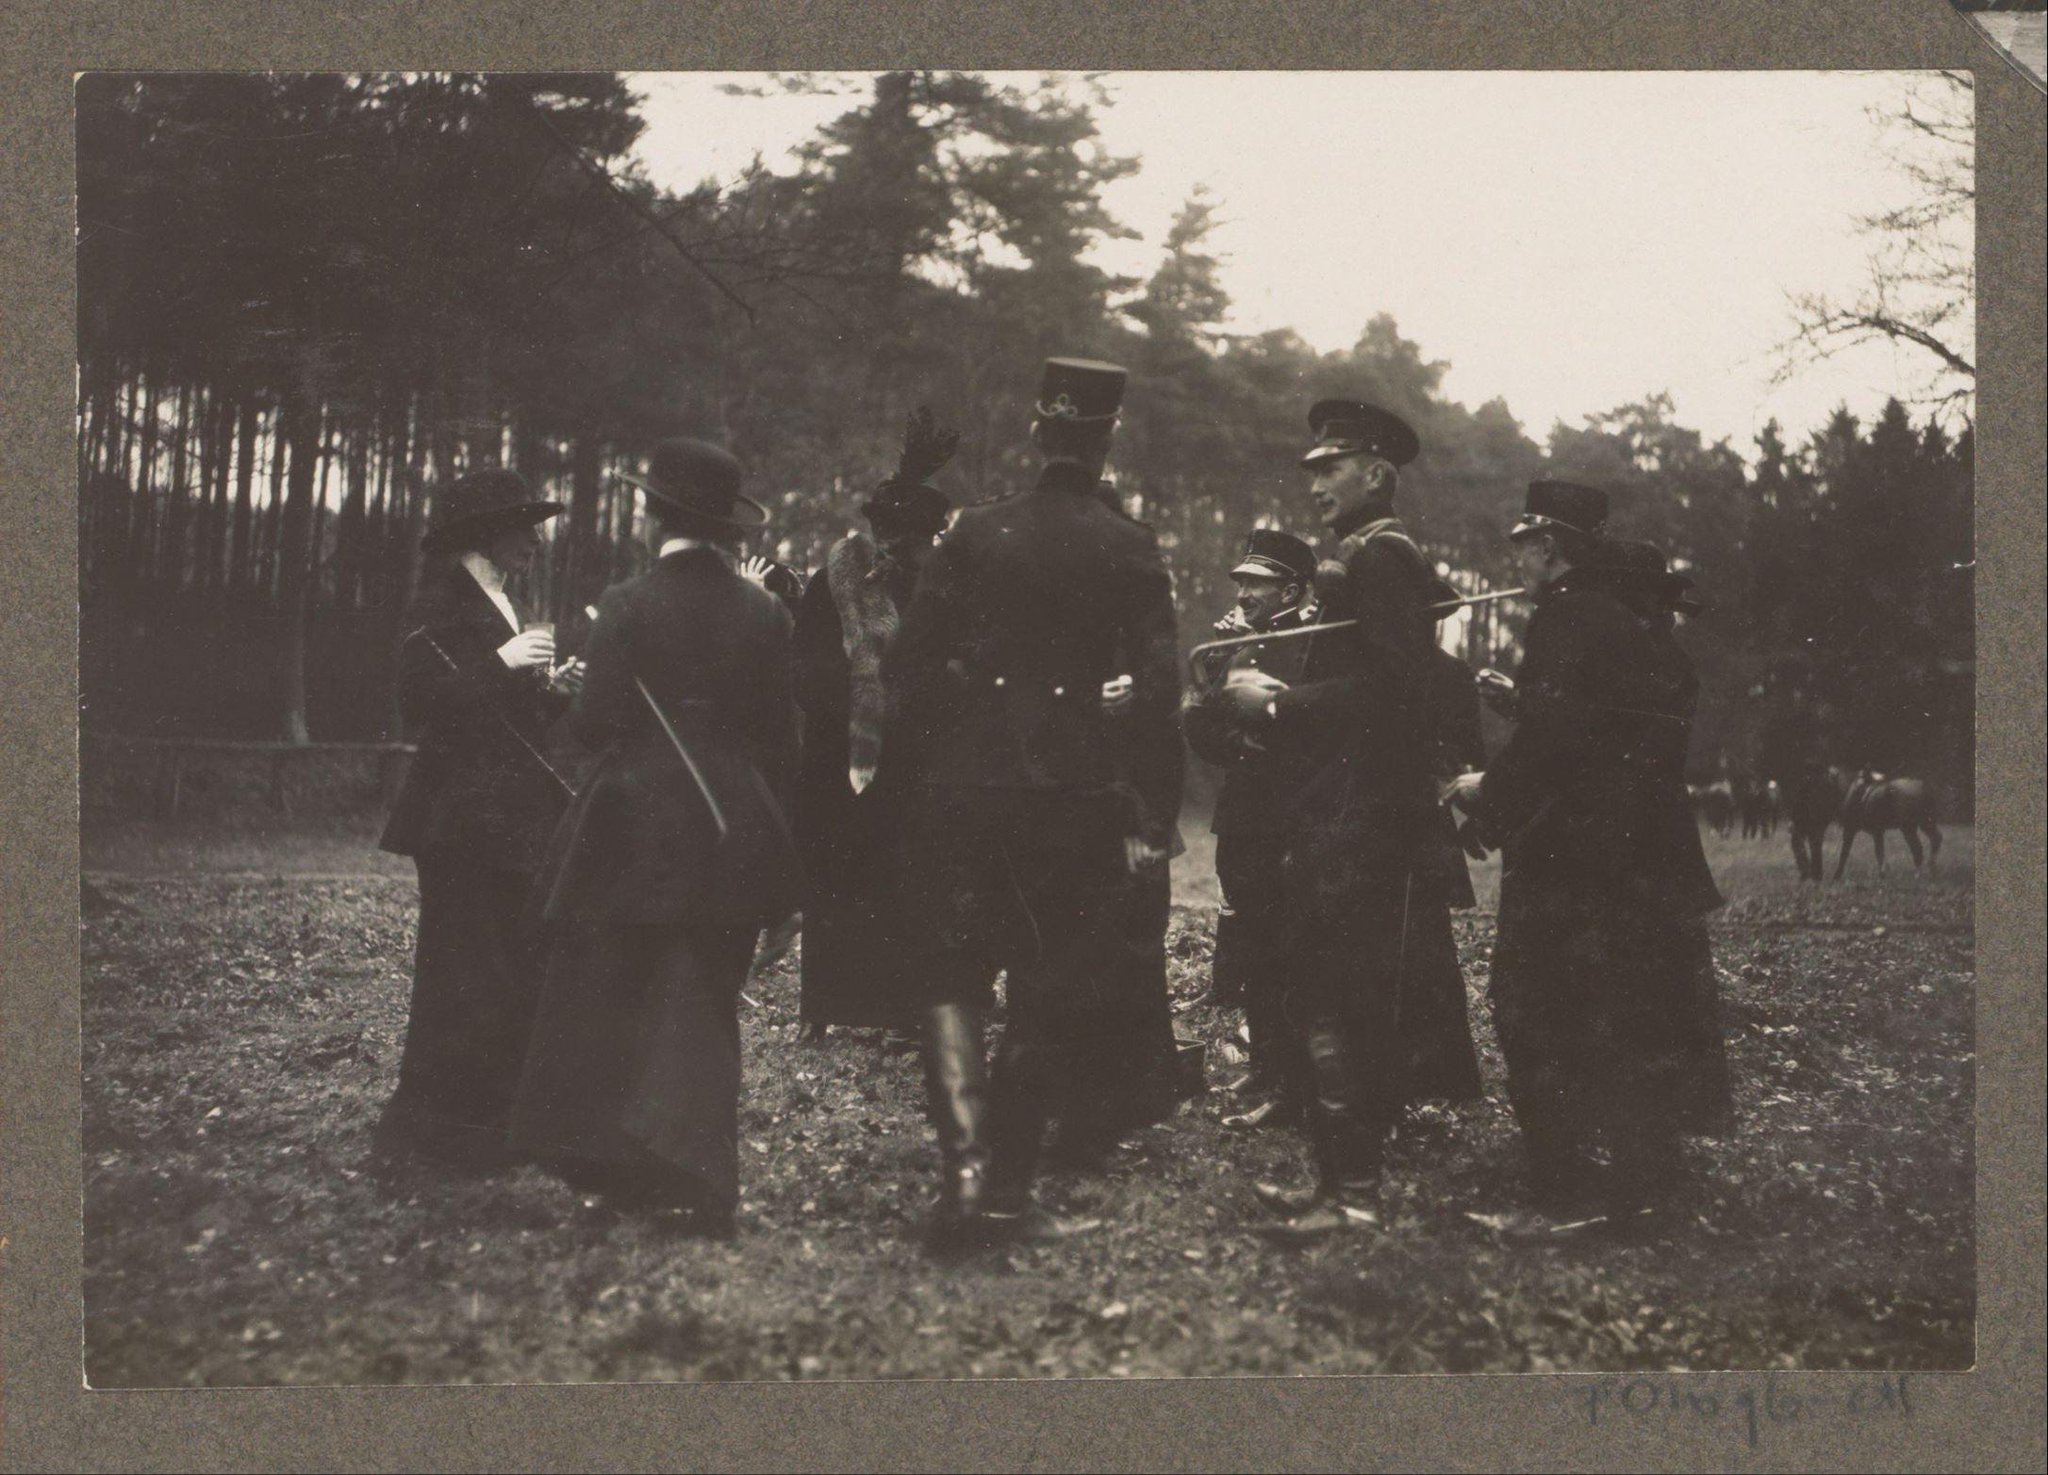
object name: photograph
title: Ruitertafereel op Koninklijke Houtvesterij Het Loo: groep ruiters bij een bos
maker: Anonymous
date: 1900-1925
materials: photographic support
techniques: gelatin silver print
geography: het loo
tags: hunting, chase, hunting-ground, forest, wood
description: Onderdeel van Fotoalbum van de heer Brams, opperhoutvester van koningin Wilhelmina op Koninklijke Houtvesterij Het Loo.